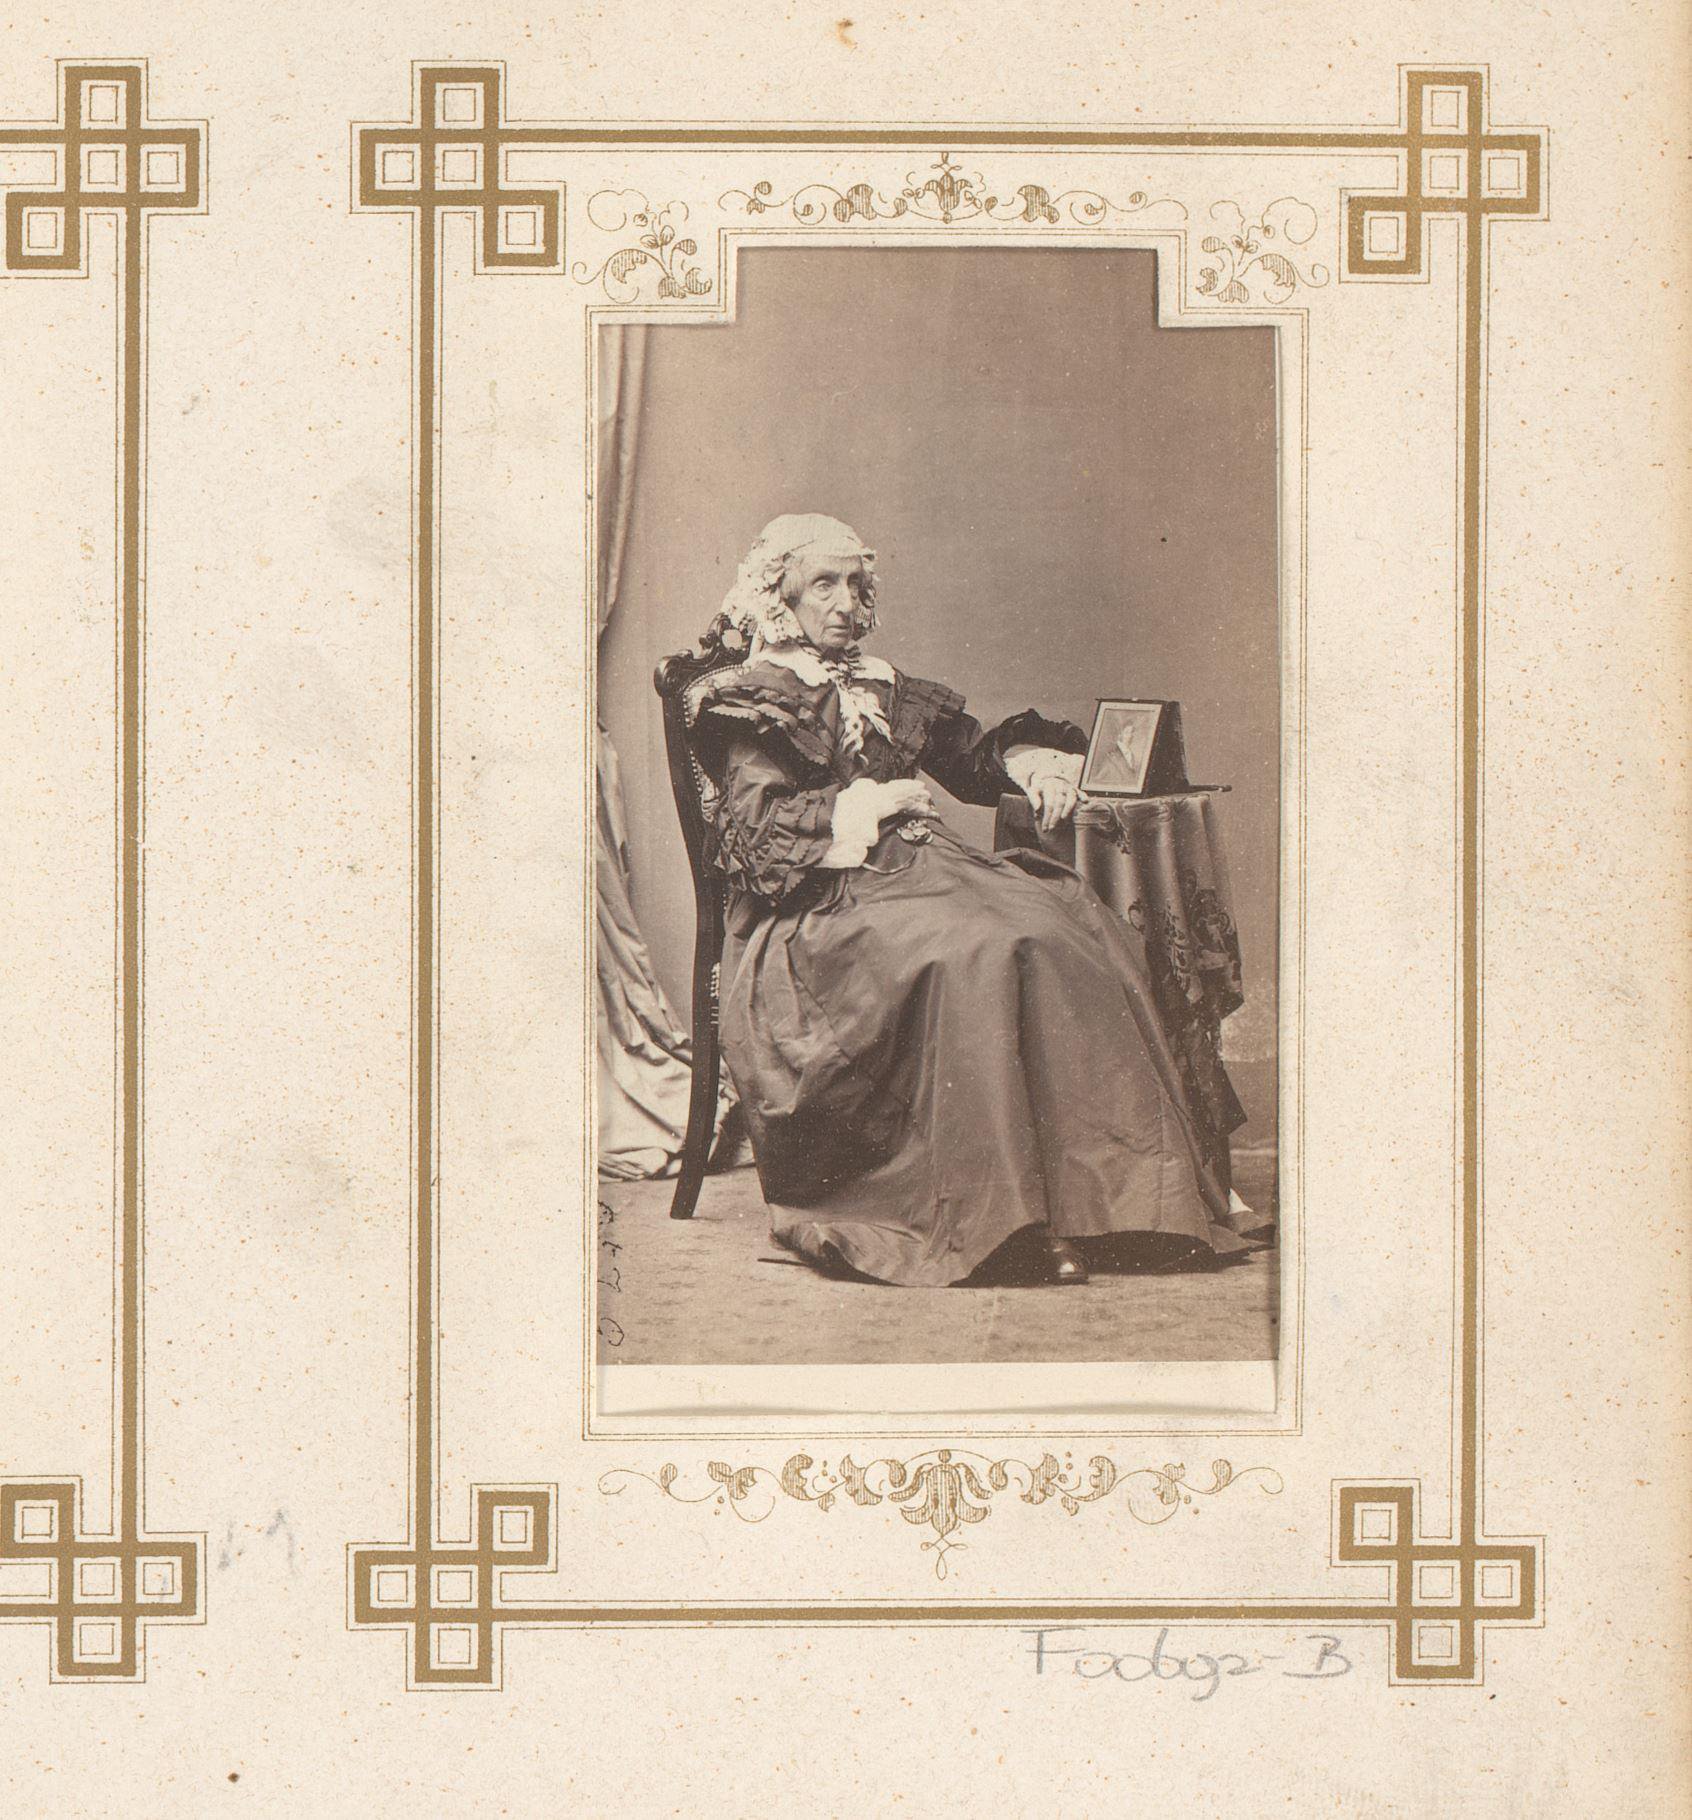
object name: album leaf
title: Portret van een oude vrouw bij een tafel met fotolijst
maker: Anonymous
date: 1855-1880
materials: cardboard, photographic support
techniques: albumen print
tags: old woman, frame of painting, etc.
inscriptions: inscription: ‘Ct.J.G.’